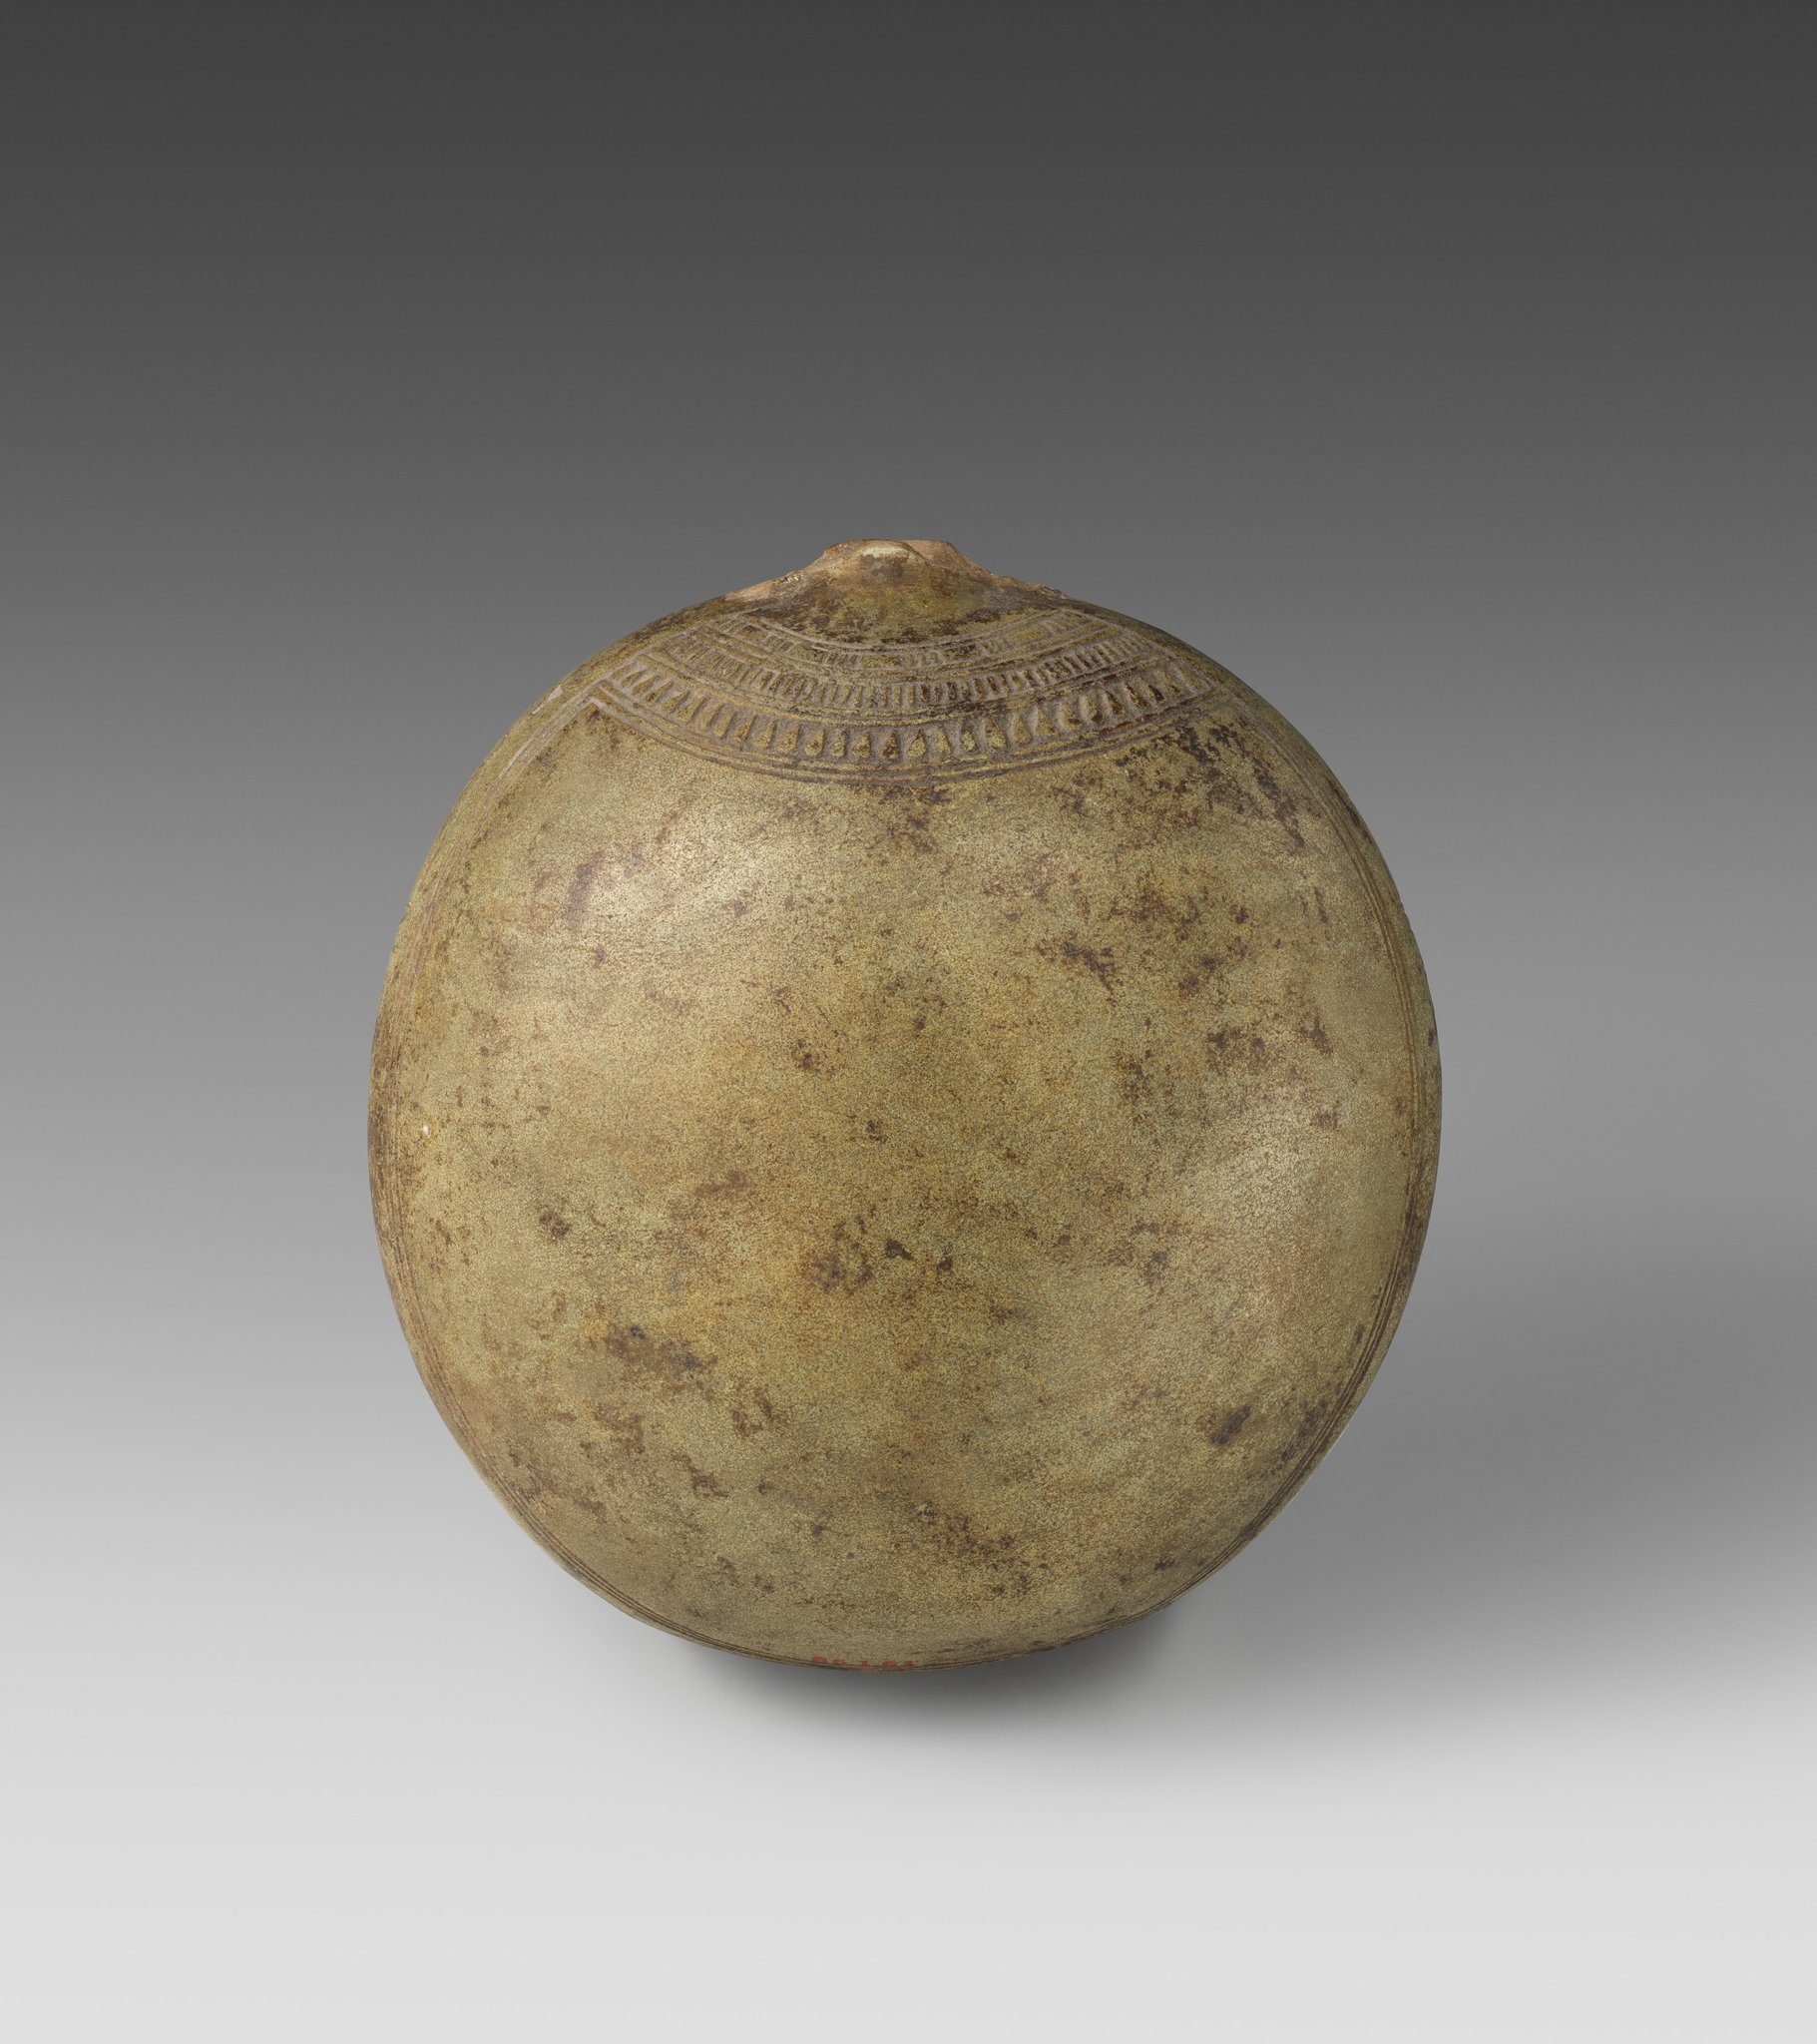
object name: lentoid bottle, new year's bottle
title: Lentoid Bottle ("New Year's Bottle")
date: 664-332 BCE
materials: faience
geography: egypt